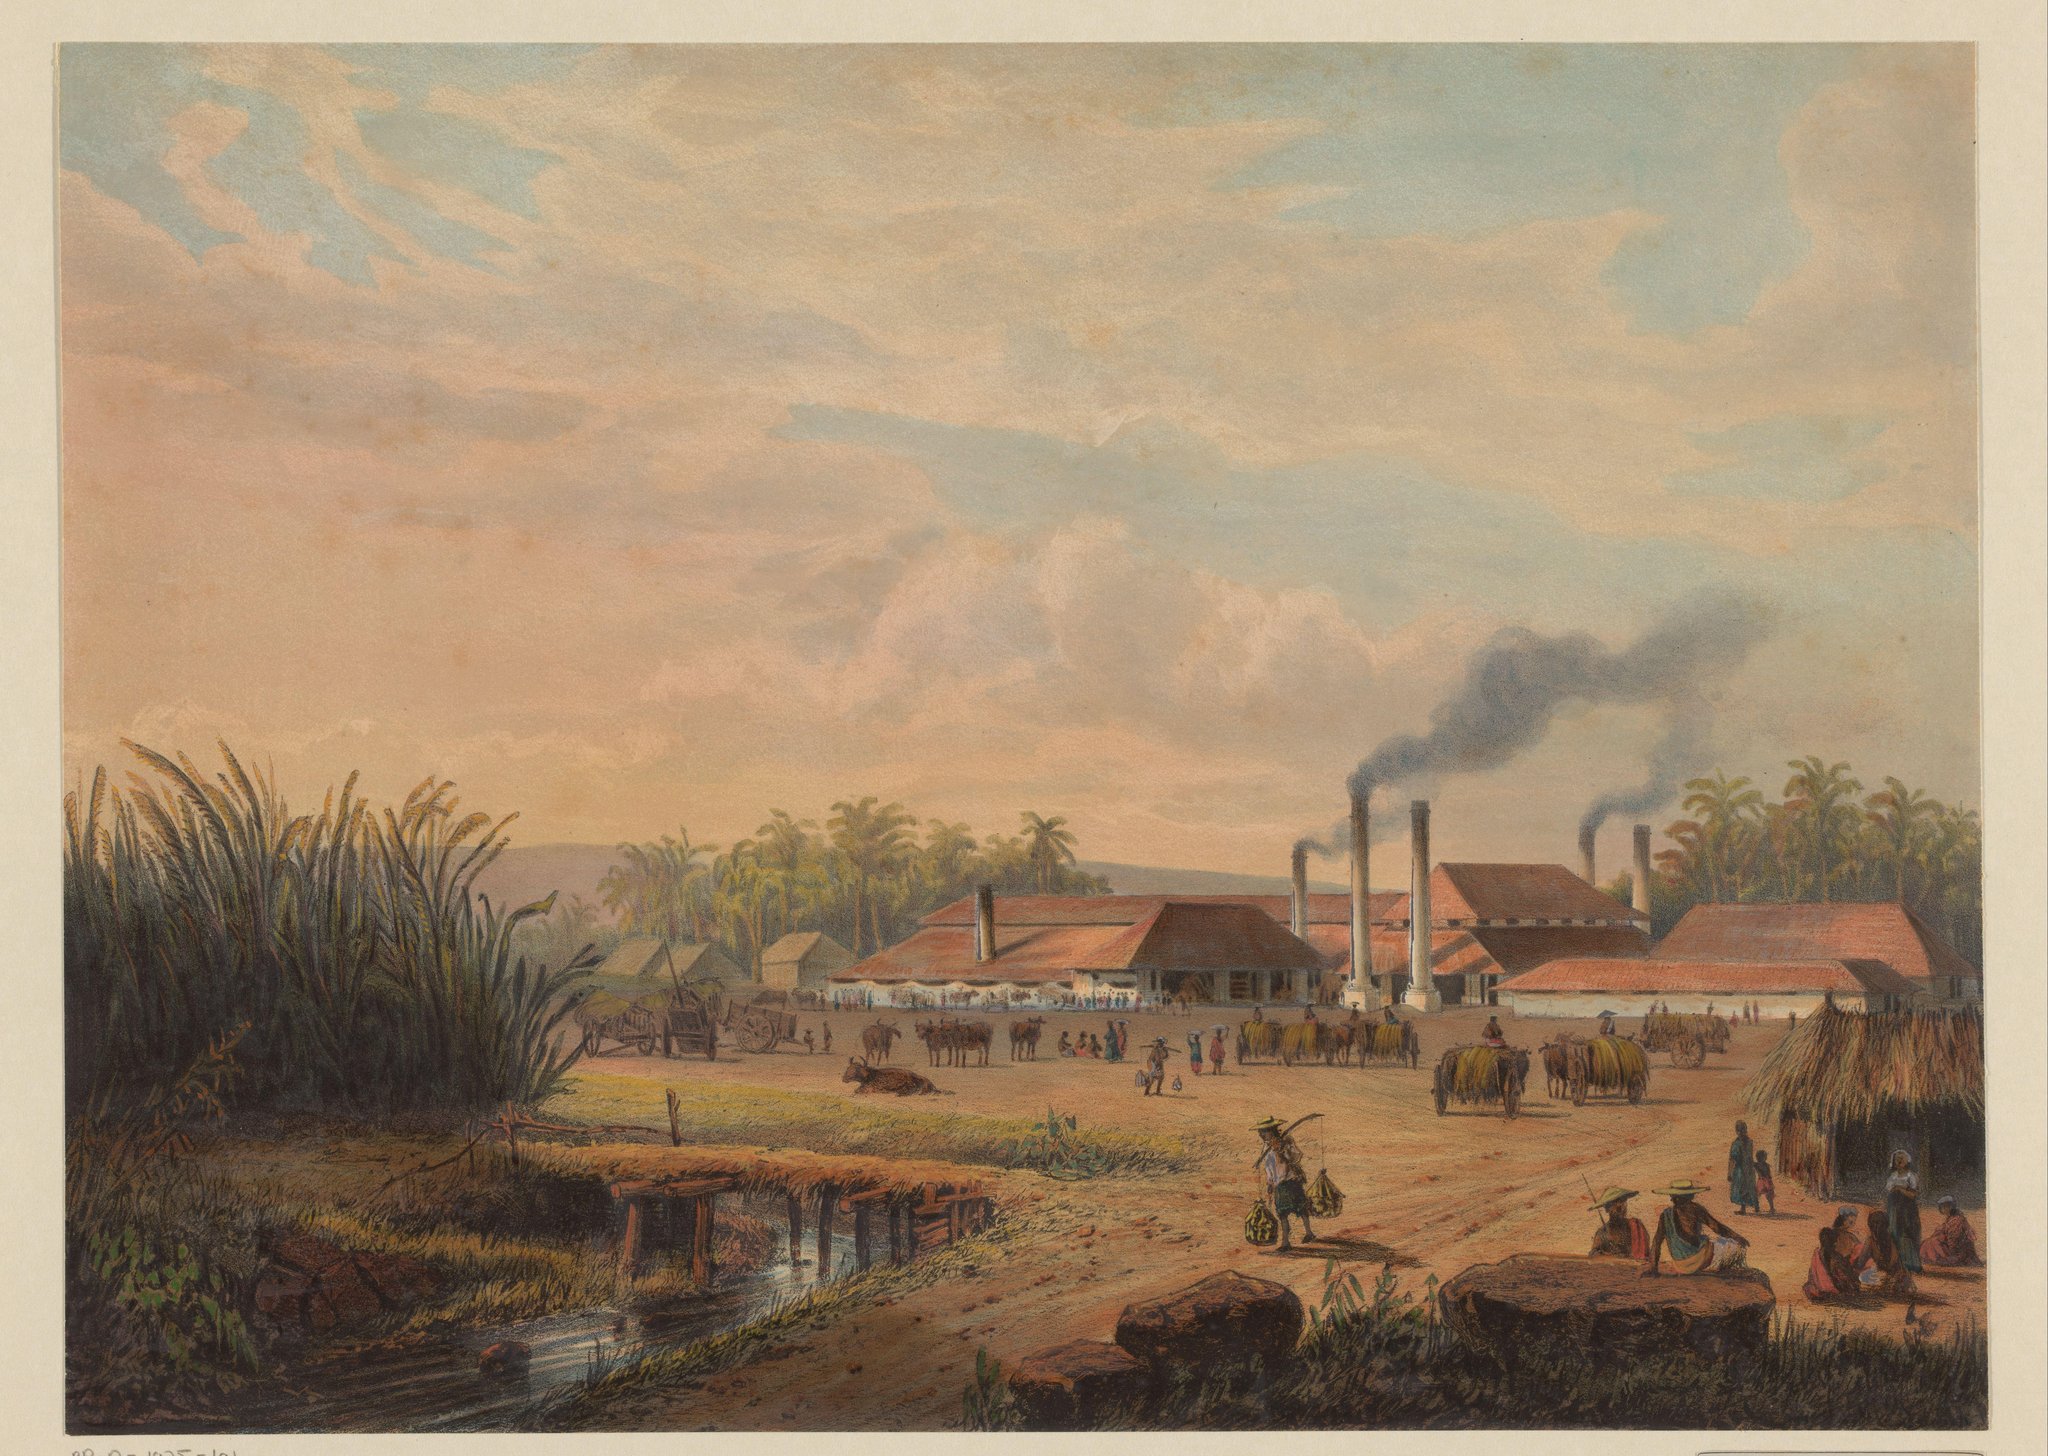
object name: print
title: Gezicht op de suikerfabriek in Pangka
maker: johan conrad greive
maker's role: draughtsman, painter, print maker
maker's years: 1837-1891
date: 1869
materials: paper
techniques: lithograph, hand coloring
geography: dutch east indies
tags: factory in landscape, landscapes in tropical and sub-tropical regions, java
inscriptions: collector's mark: Lugt 2228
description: De schoorstenen van de fabriek roken. Op het terrein zijn figuren in de weer. De prent maakt deel uit van een omslag met een tekstblad en 24 losse prenten.